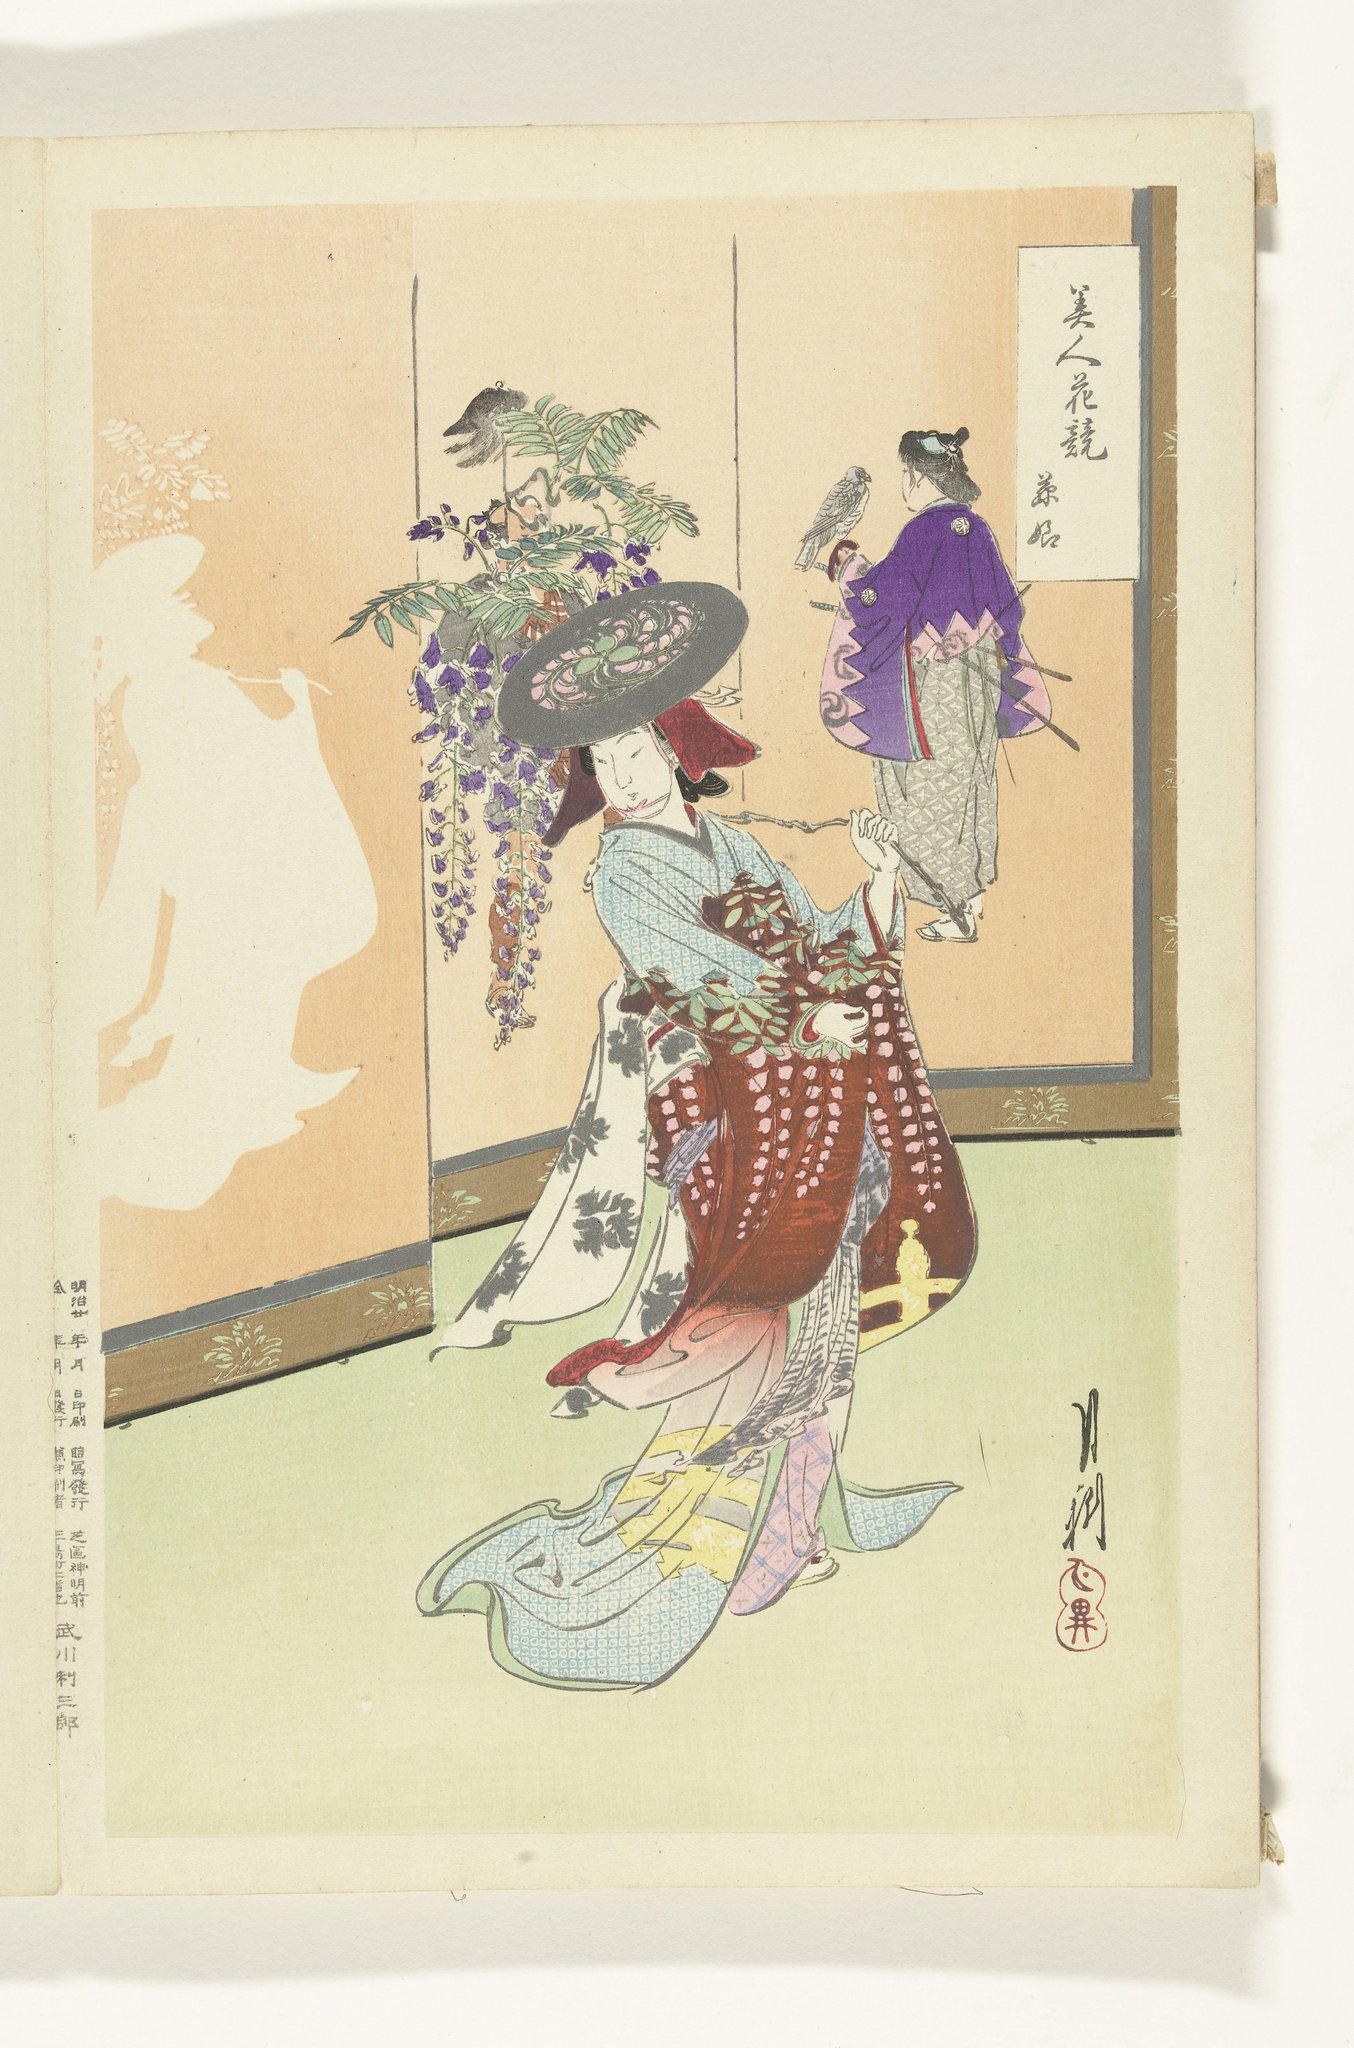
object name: print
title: Bijin hana kurabe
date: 1887-1896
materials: gold powder, paper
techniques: blind stamped, woodcut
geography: japan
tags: woman dancing alone, screen, folding screen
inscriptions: collector's mark: Lugt 2760, collector's mark: Lugt 2228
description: Dansende vrouw met wisteria tak in linker hand; op de achtergrond een kamerscherm waarop haar silhouet in wit en de afbeelding van een man met roofvogel op linker hand.